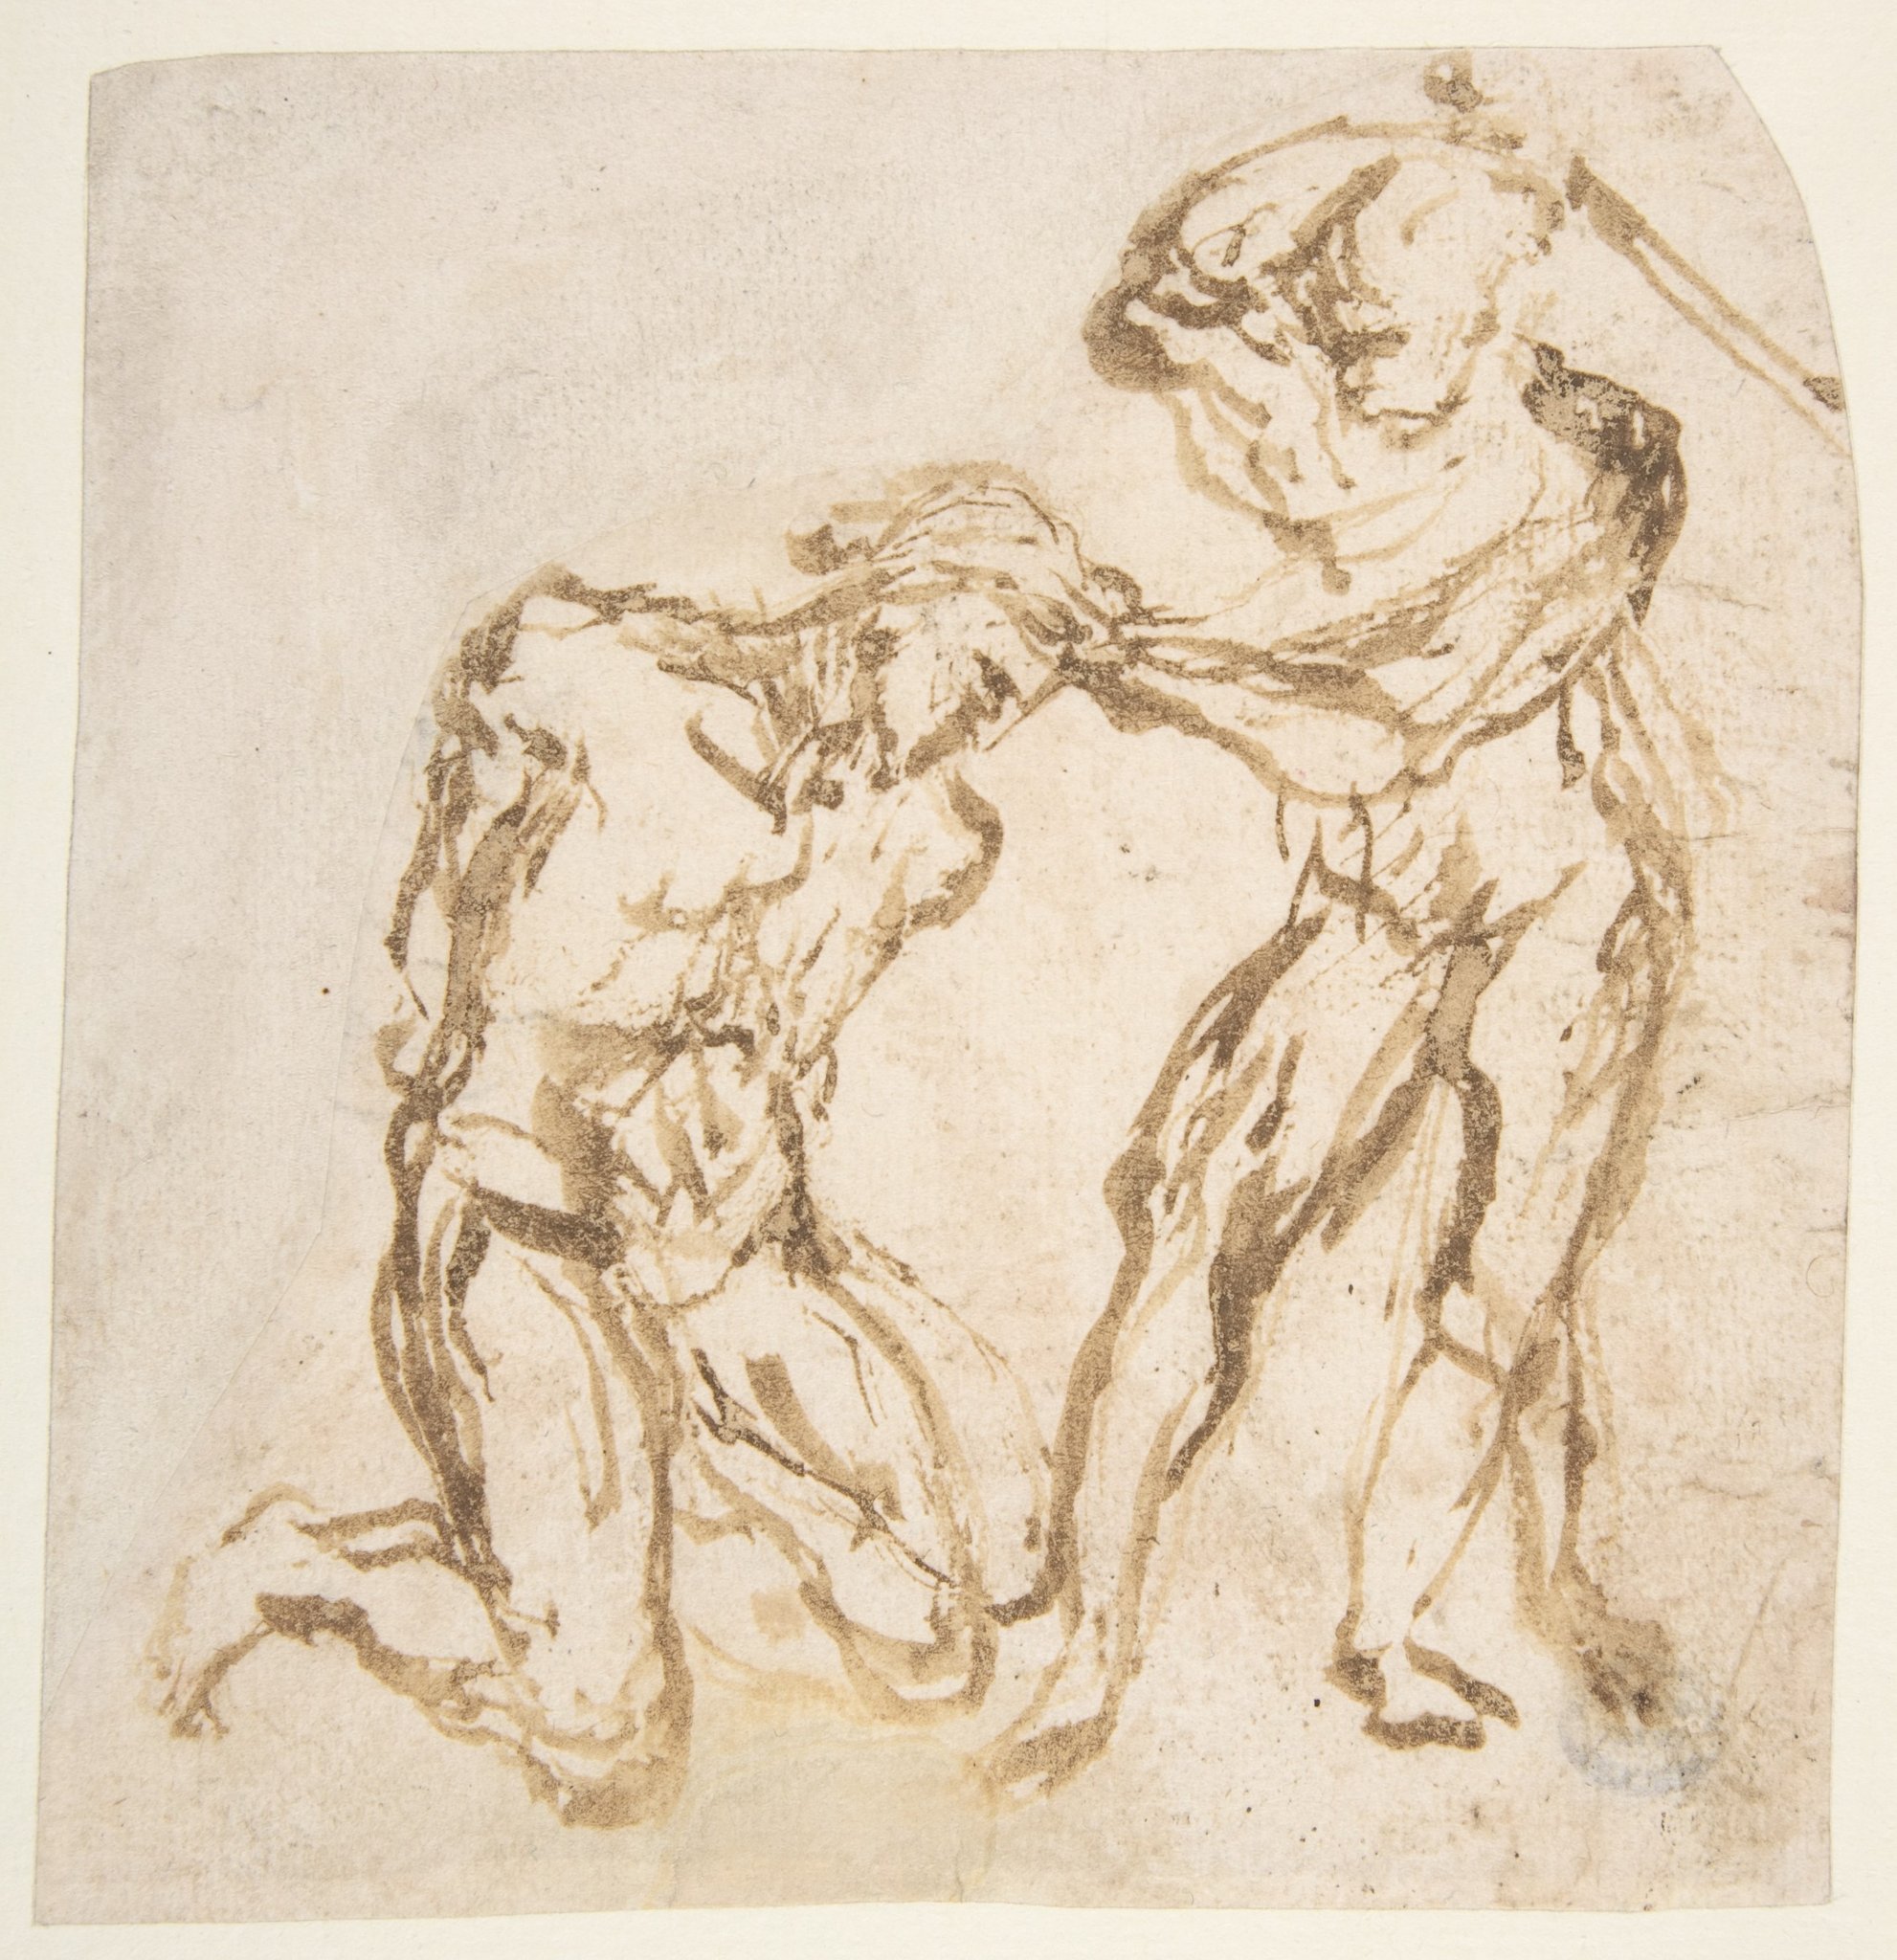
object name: drawing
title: Beheading of a Kneeling Nude Man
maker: romulo cincinnato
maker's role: artist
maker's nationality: italian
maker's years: 1540-1597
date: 1502-1593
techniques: brush, wash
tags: swords,male nudes